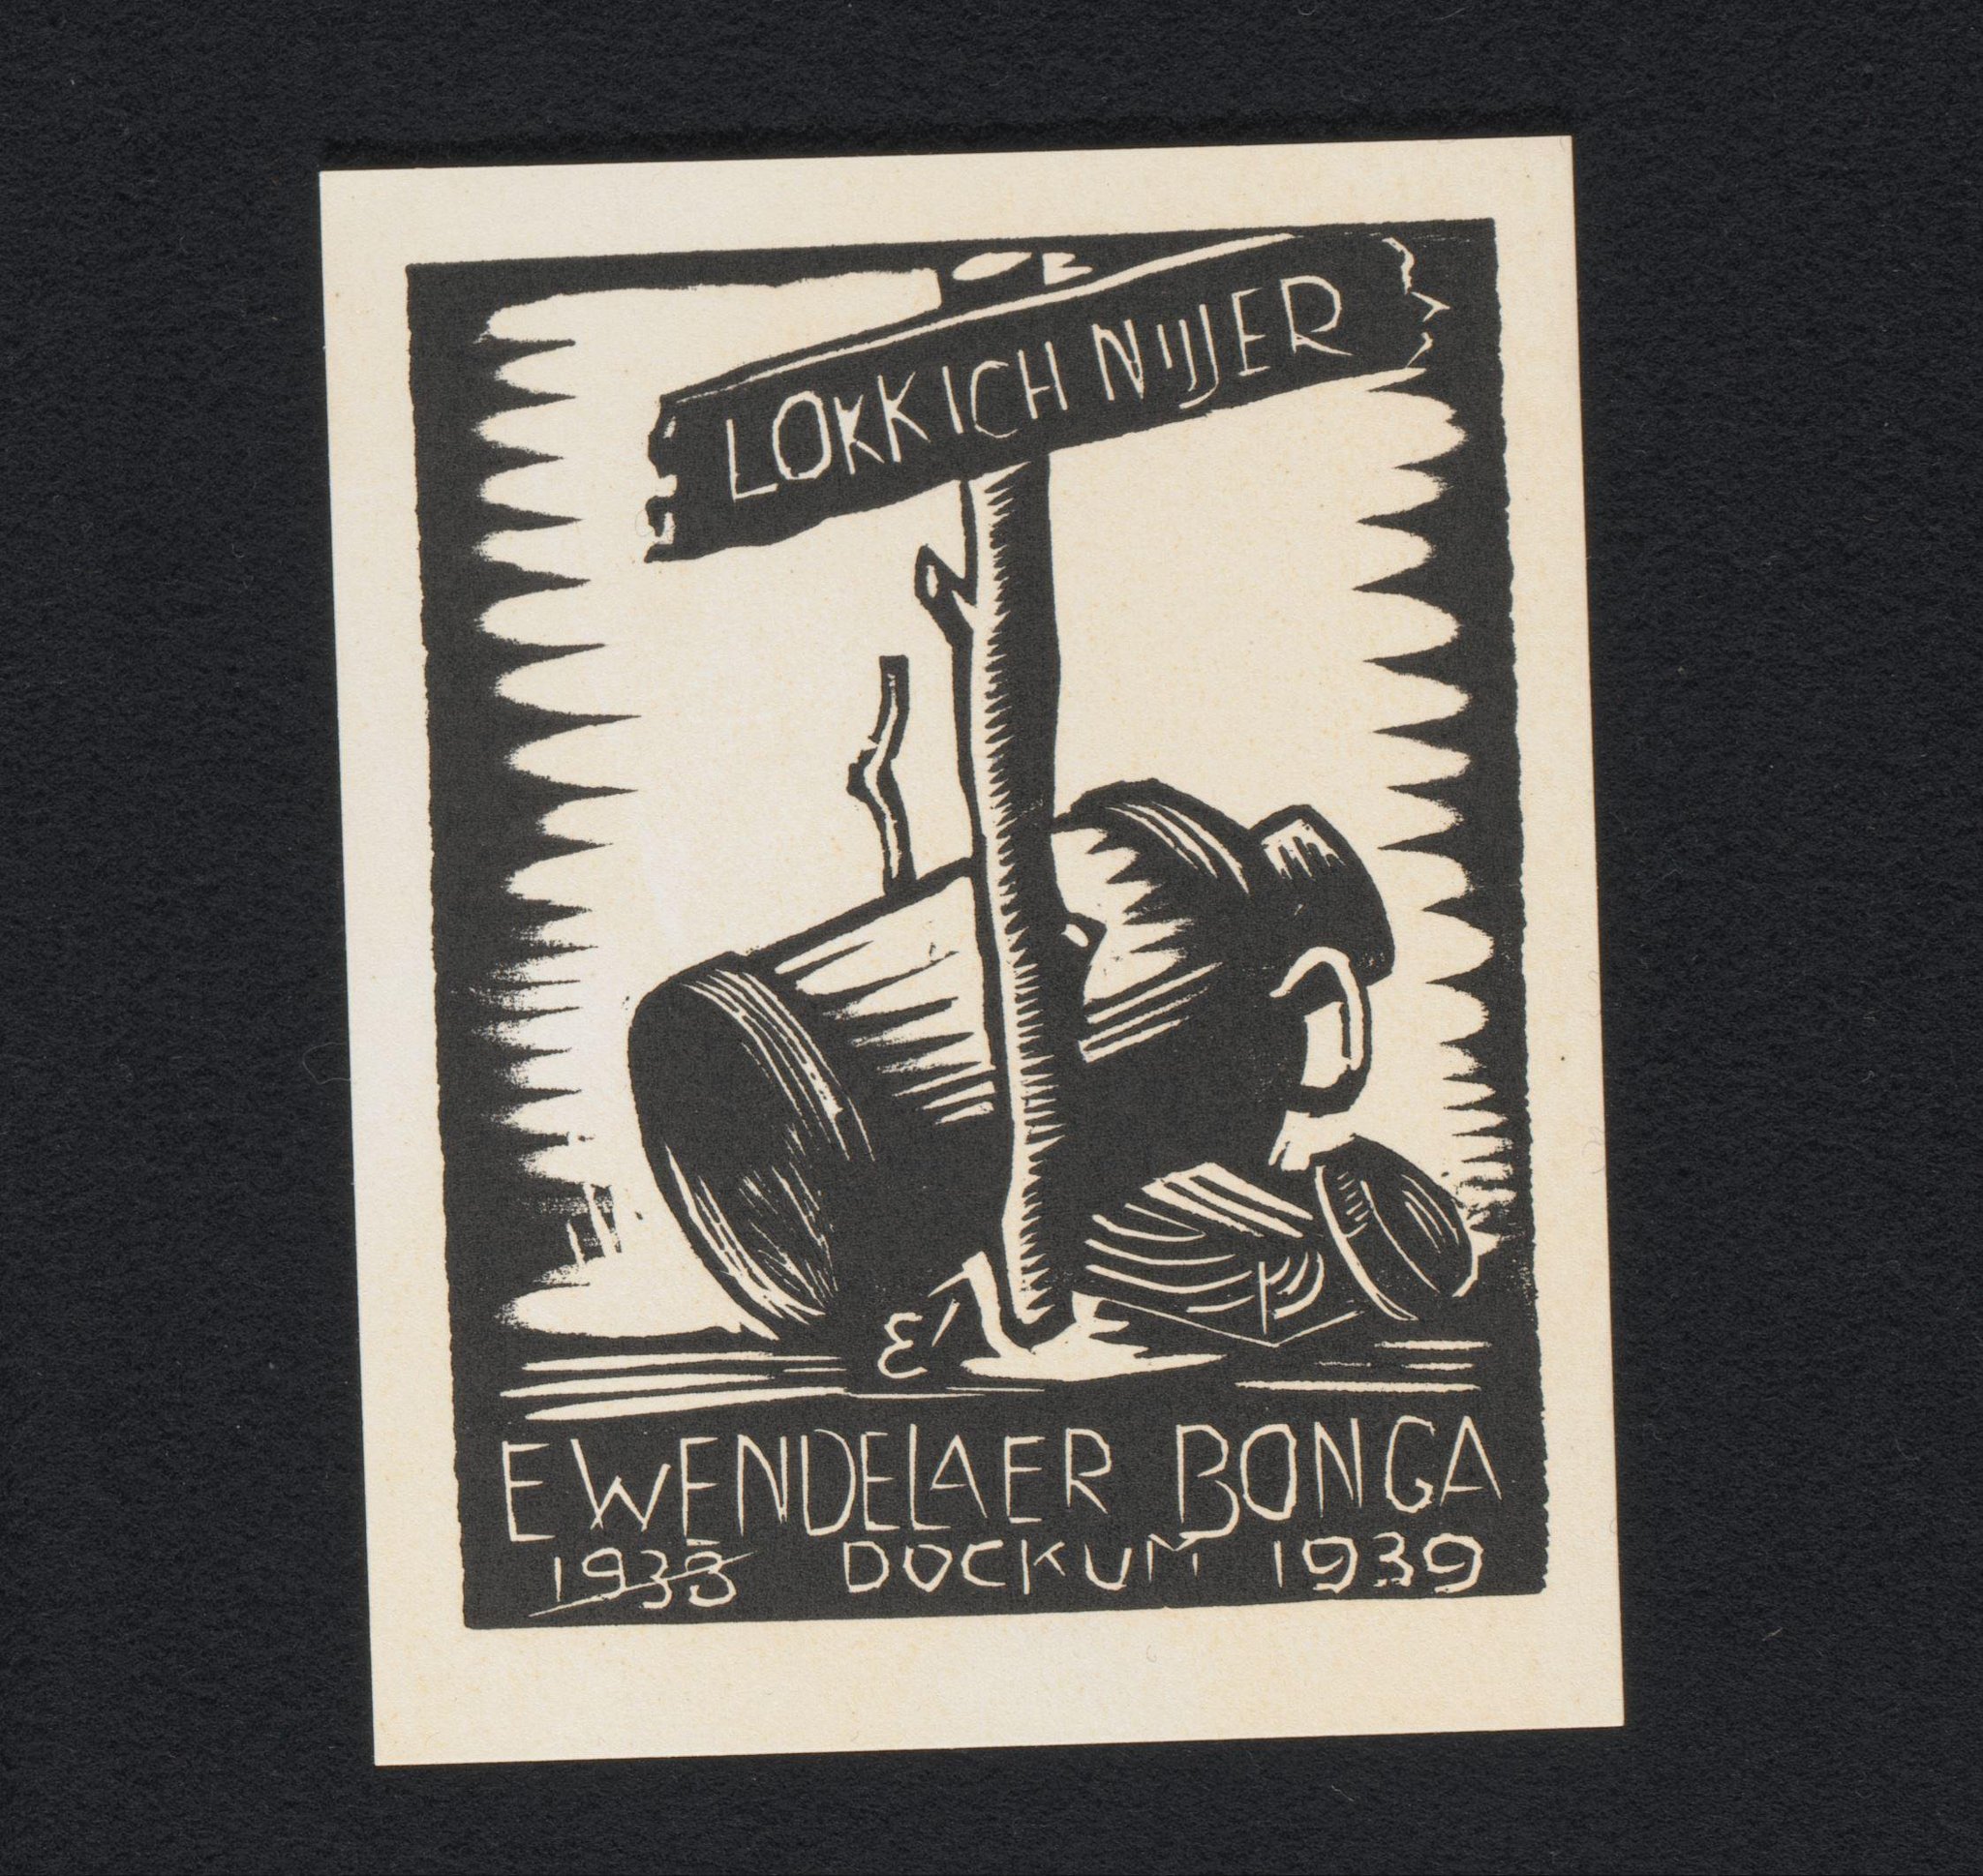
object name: new year card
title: Lokkich Nijjer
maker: e. wendelaer bonga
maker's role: print maker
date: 1938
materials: paper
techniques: linocut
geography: netherlands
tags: e. wendelaer bonga, container of metal: bucket, can, canister, drum, tin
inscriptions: date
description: Deze prent maakt deel uit van een omslag met 22 prenten.